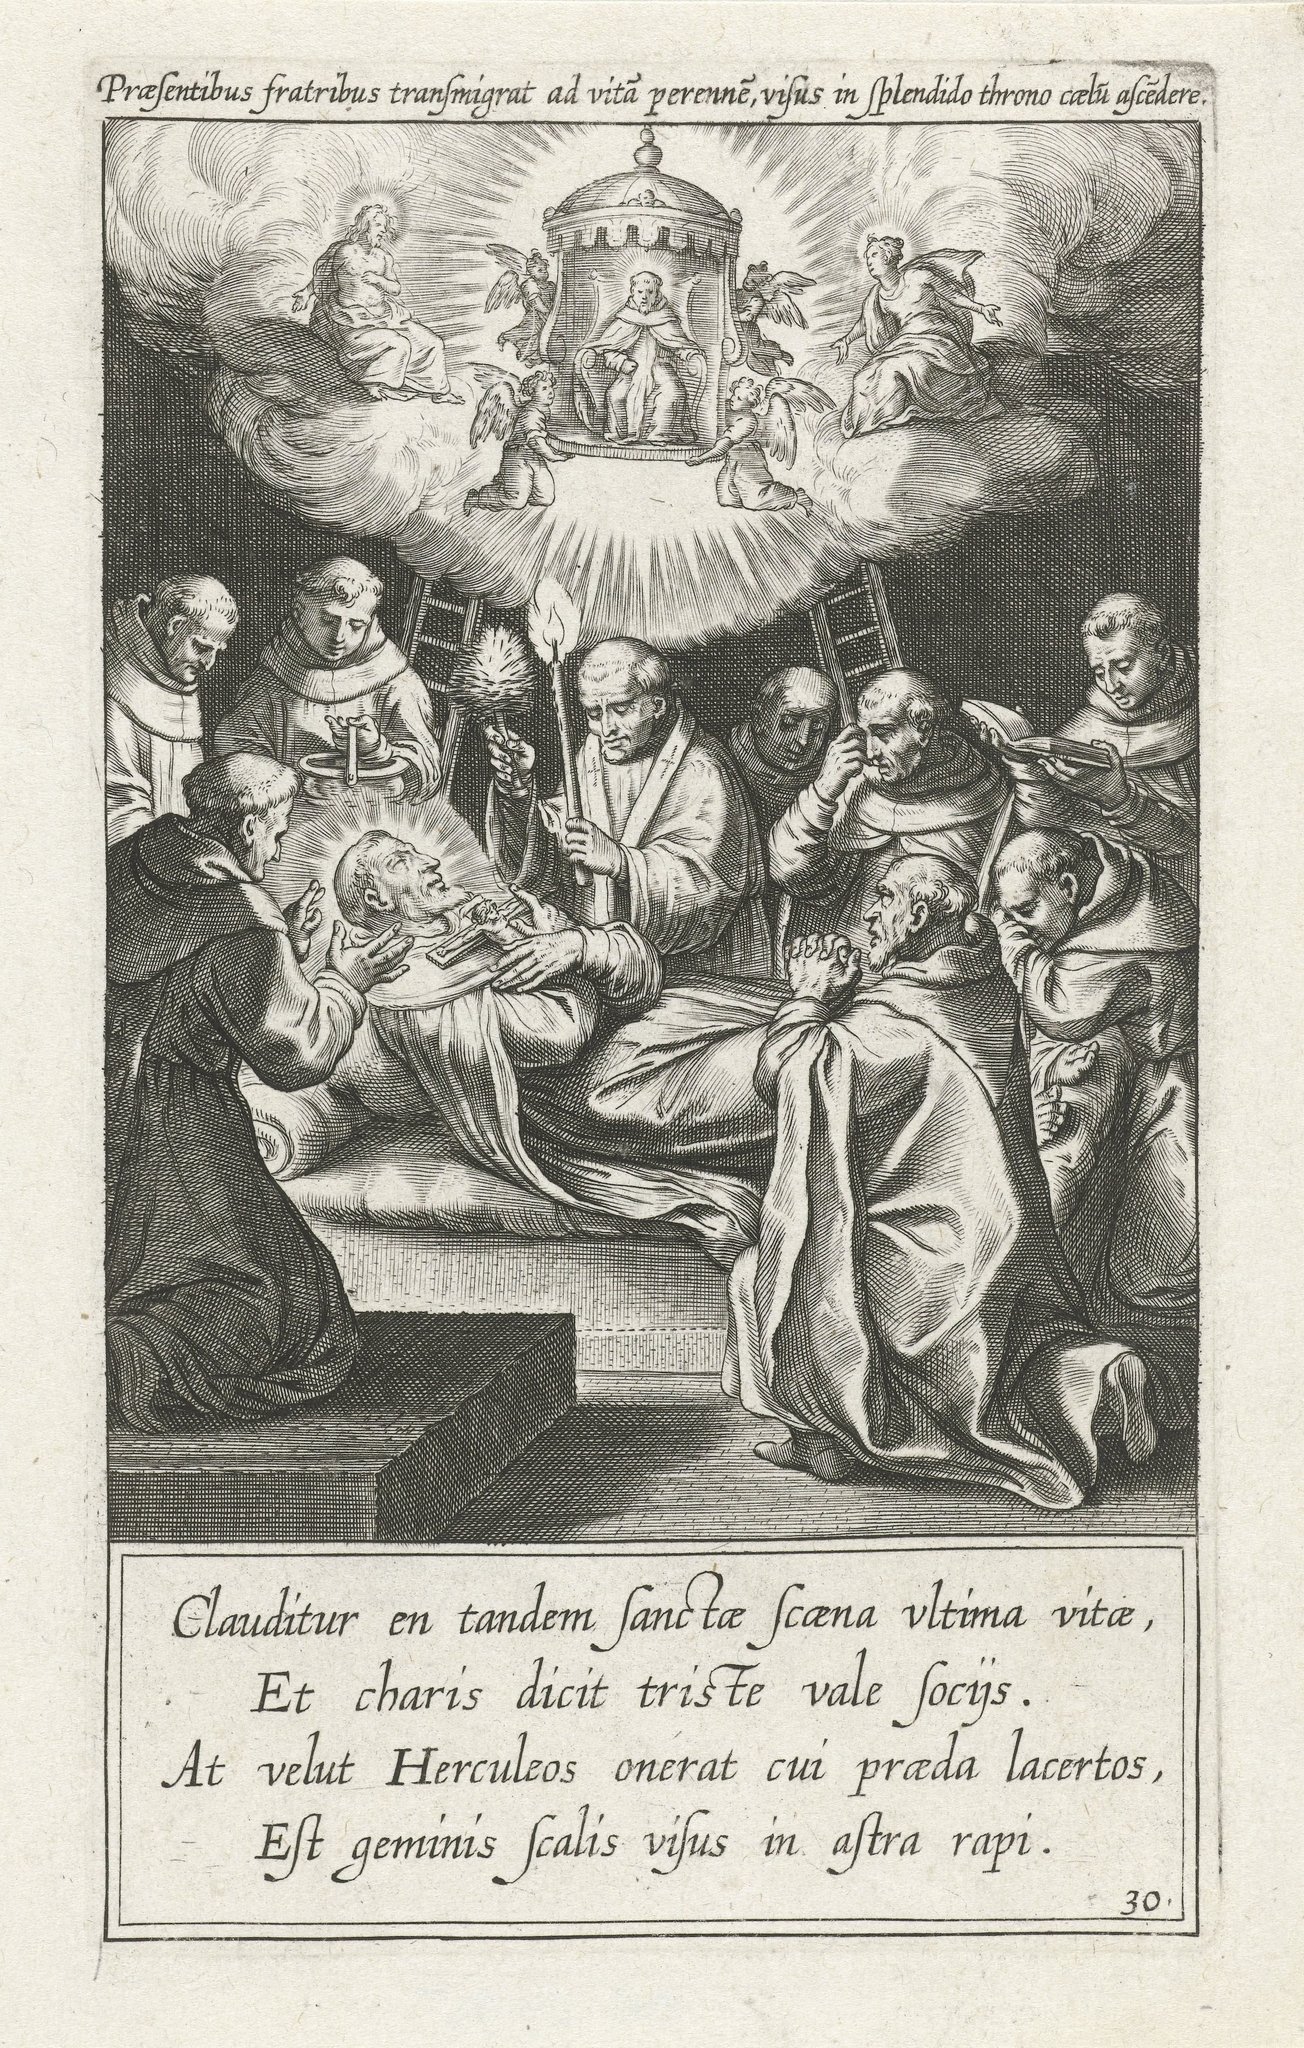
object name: print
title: Sterfbed van de heilige Dominicus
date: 1611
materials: paper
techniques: engraving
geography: antwerp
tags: dominic(us) guzman of calerueja, founder of the order of preachers (or dominican (black) friars; possible attributes: book, dog with flaming torch, lily, loaf of bread, rosary, star - death, deathbed of male saint (+ mary)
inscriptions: collector's mark: Lugt 2228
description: De heilige Dominicus sterft in zijn bed, omringd door zijn volgelingen. Een visioen boven hun hoofden toont de heilige Dominicus, getroond tussen Maria en Christus in. De prent heeft een Latijns opschrift en onderschrift en maakt deel uit van een prentserie voor een boek over het leven van de heilige Dominicus.